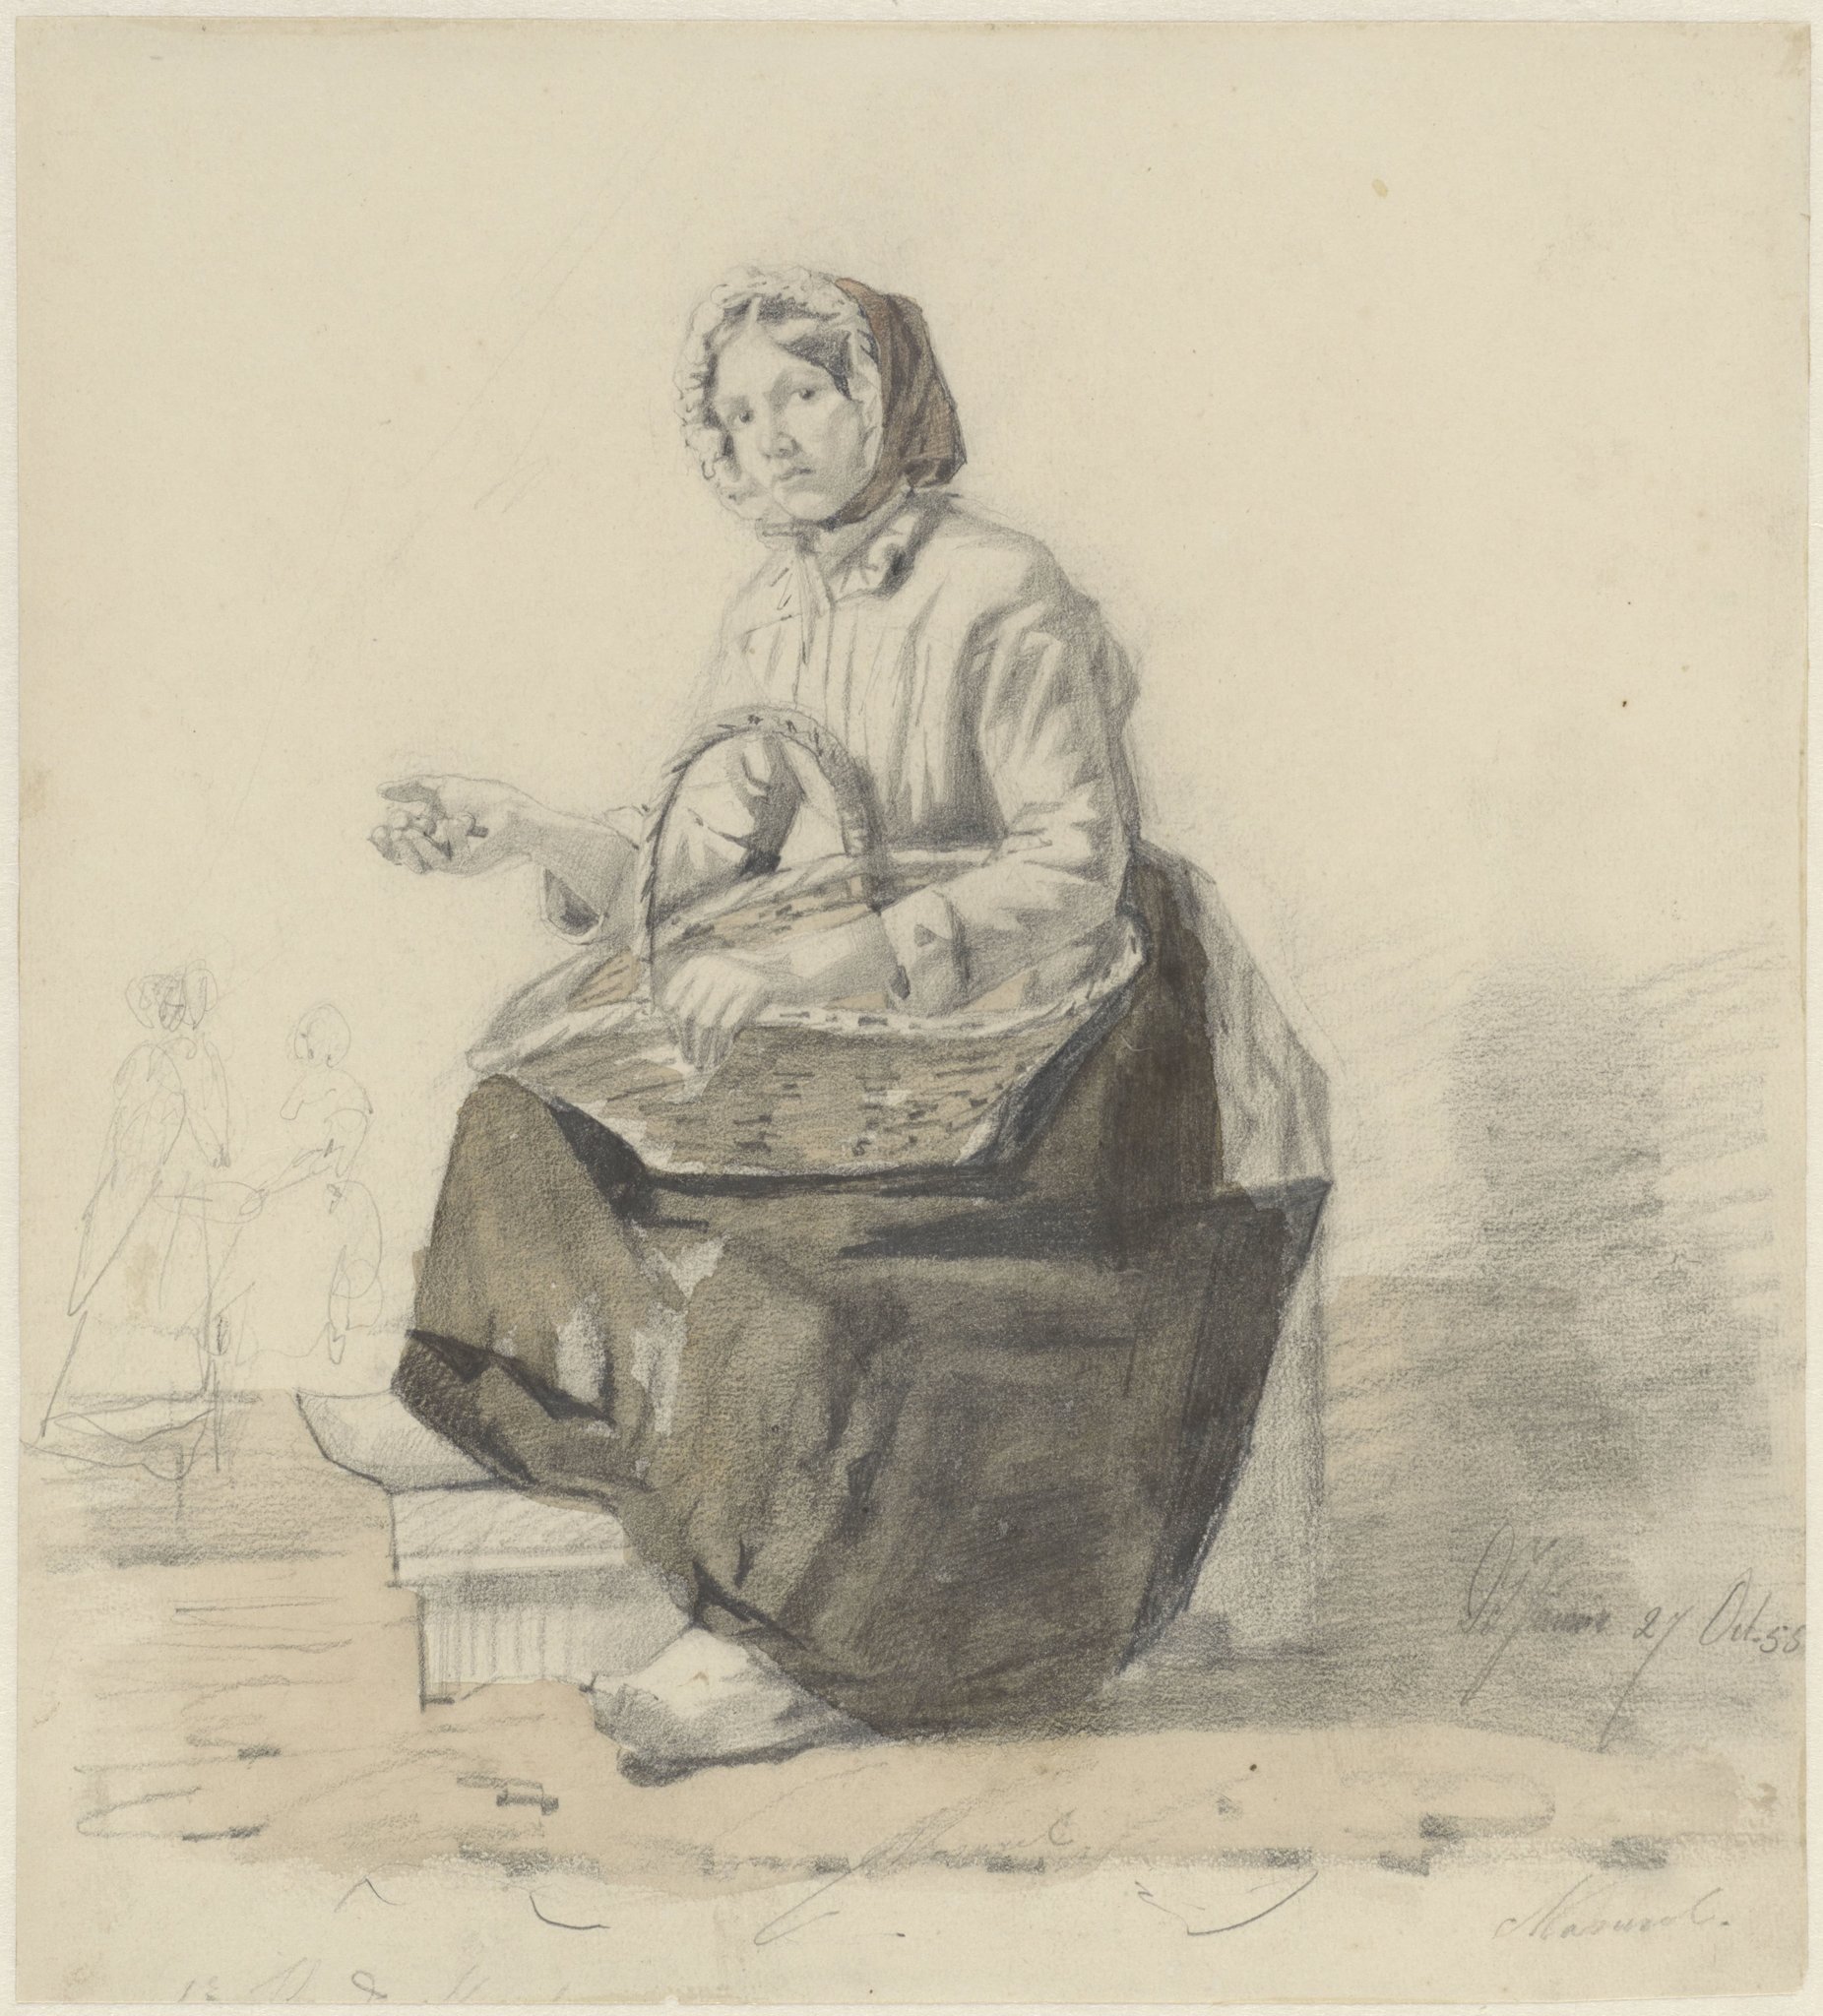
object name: drawing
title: Zittende straatverkoopster met mand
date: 1855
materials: paper, pencil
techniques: brush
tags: street-trader - bb - women engaged in trade and commerce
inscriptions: date: ‘27 Oct. 55’